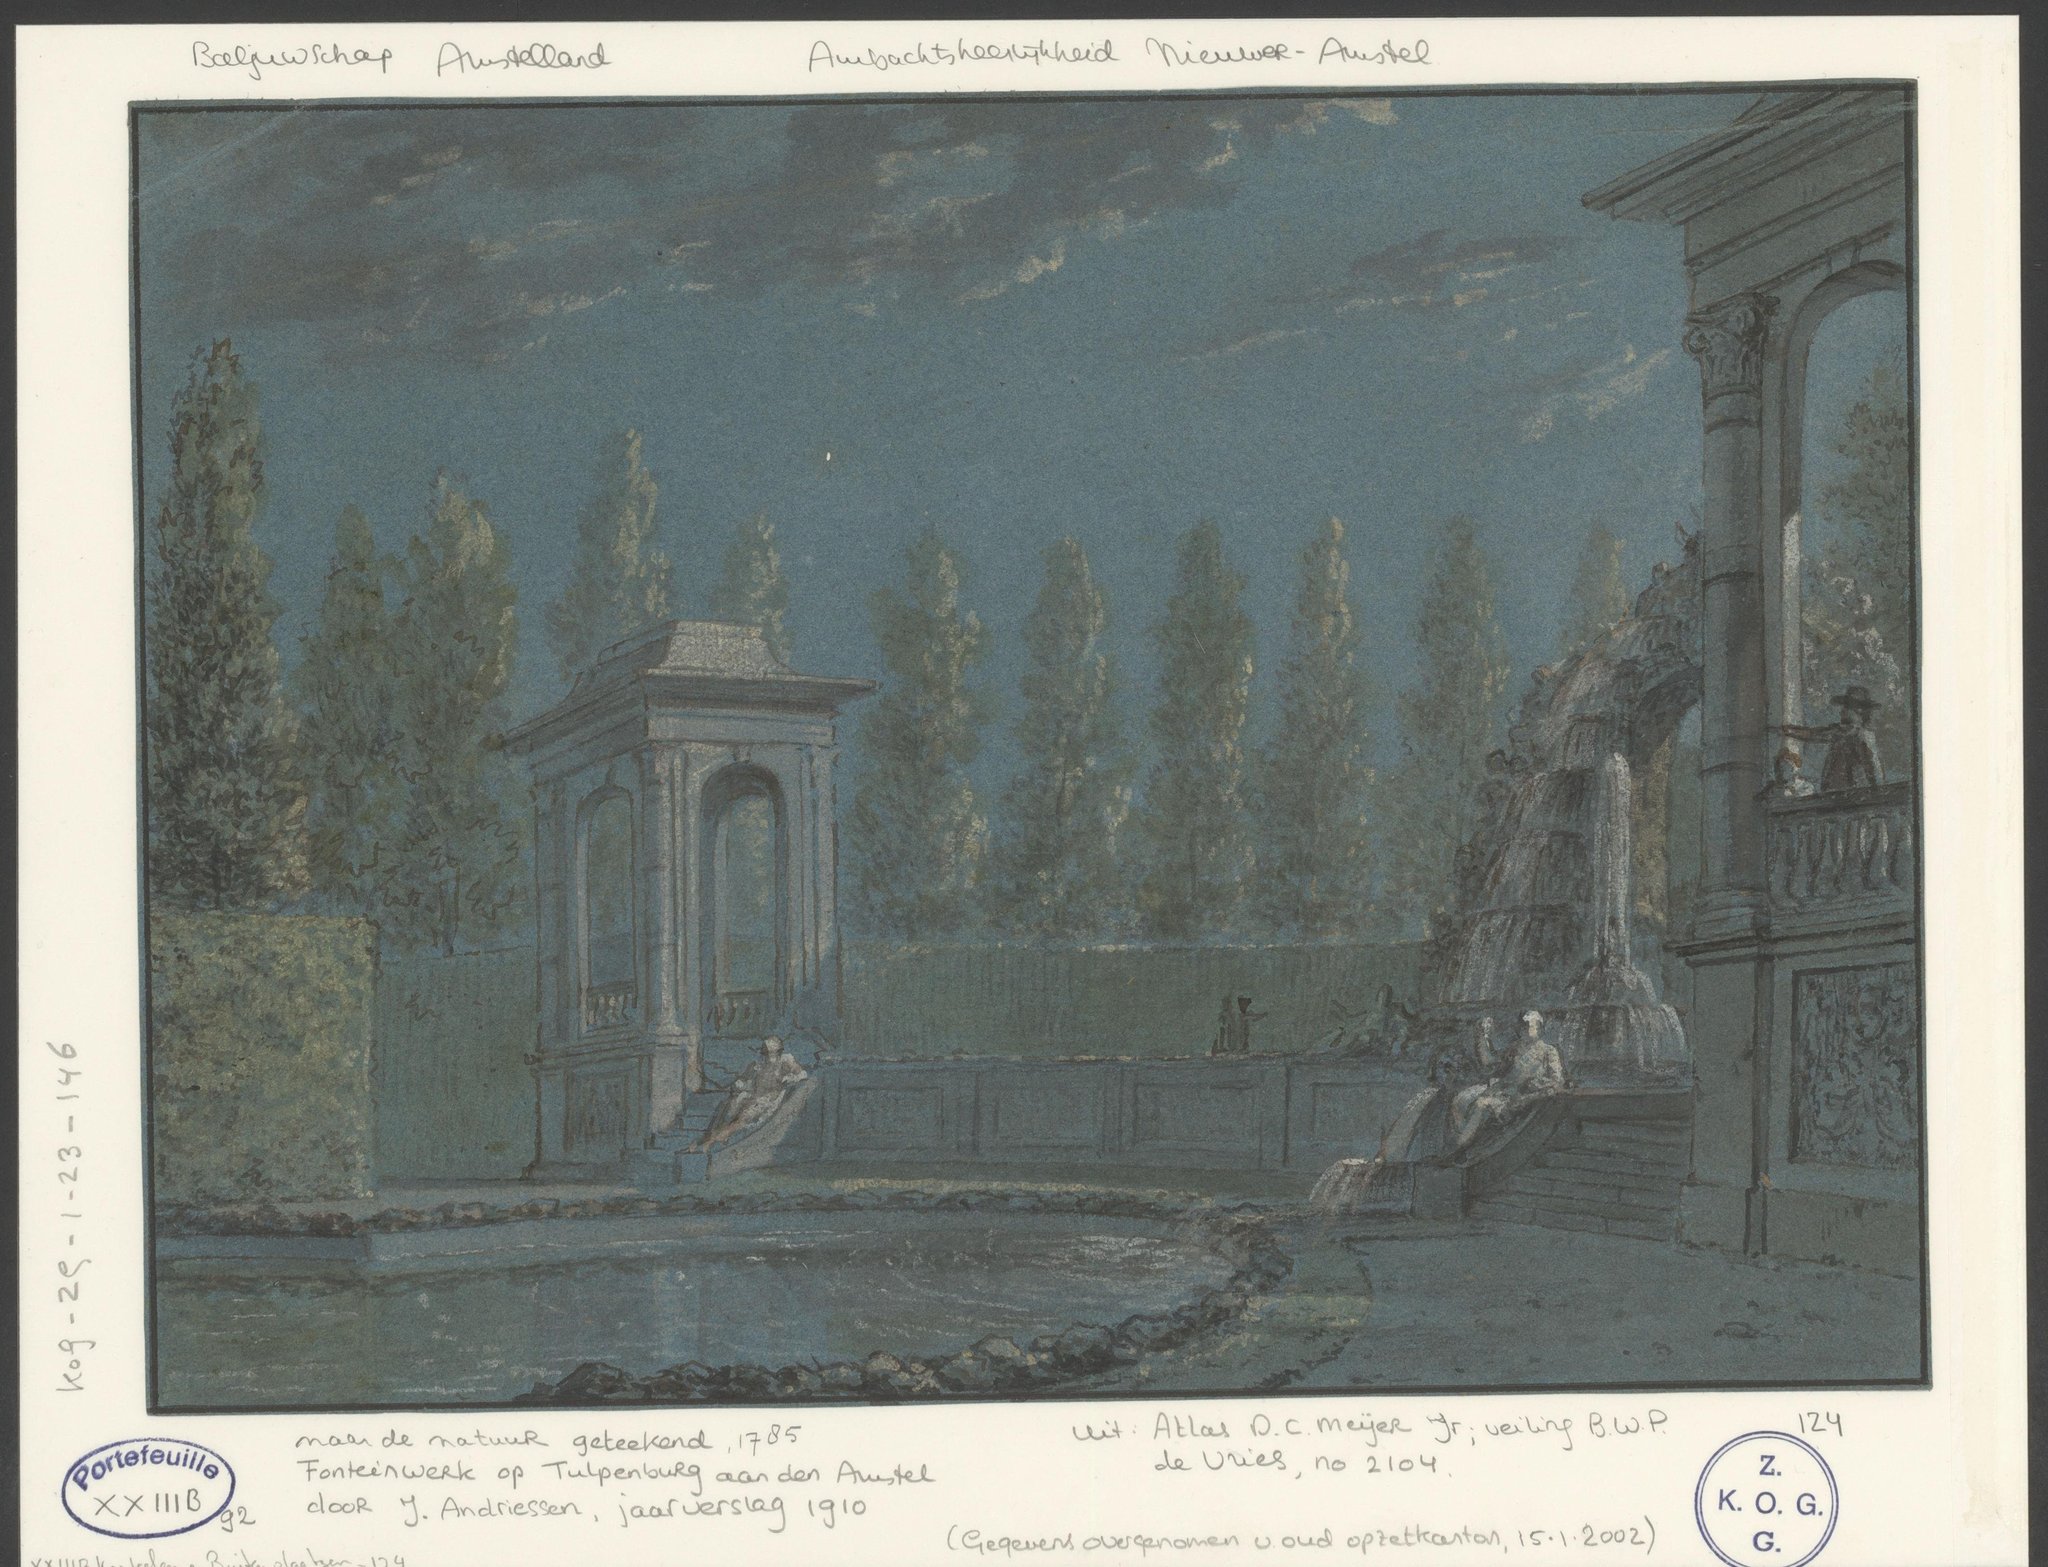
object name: drawing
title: Gezicht op de fontein van Tulpenburg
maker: jurriaan andriessen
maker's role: draughtsman, painter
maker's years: 1742-1819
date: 1785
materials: chalk, paper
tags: garden, garden pond, statues, sculptures in garden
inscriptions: stamp, collector's mark: Lugt 1641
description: Onderwerpsrubrieken binnen de Atlas Zeden en Gewoonten: Zeden en Gewoonten in Engeren Zin, De Woning. Kastelen en buitenplaatsen. Holland (vervolg.)